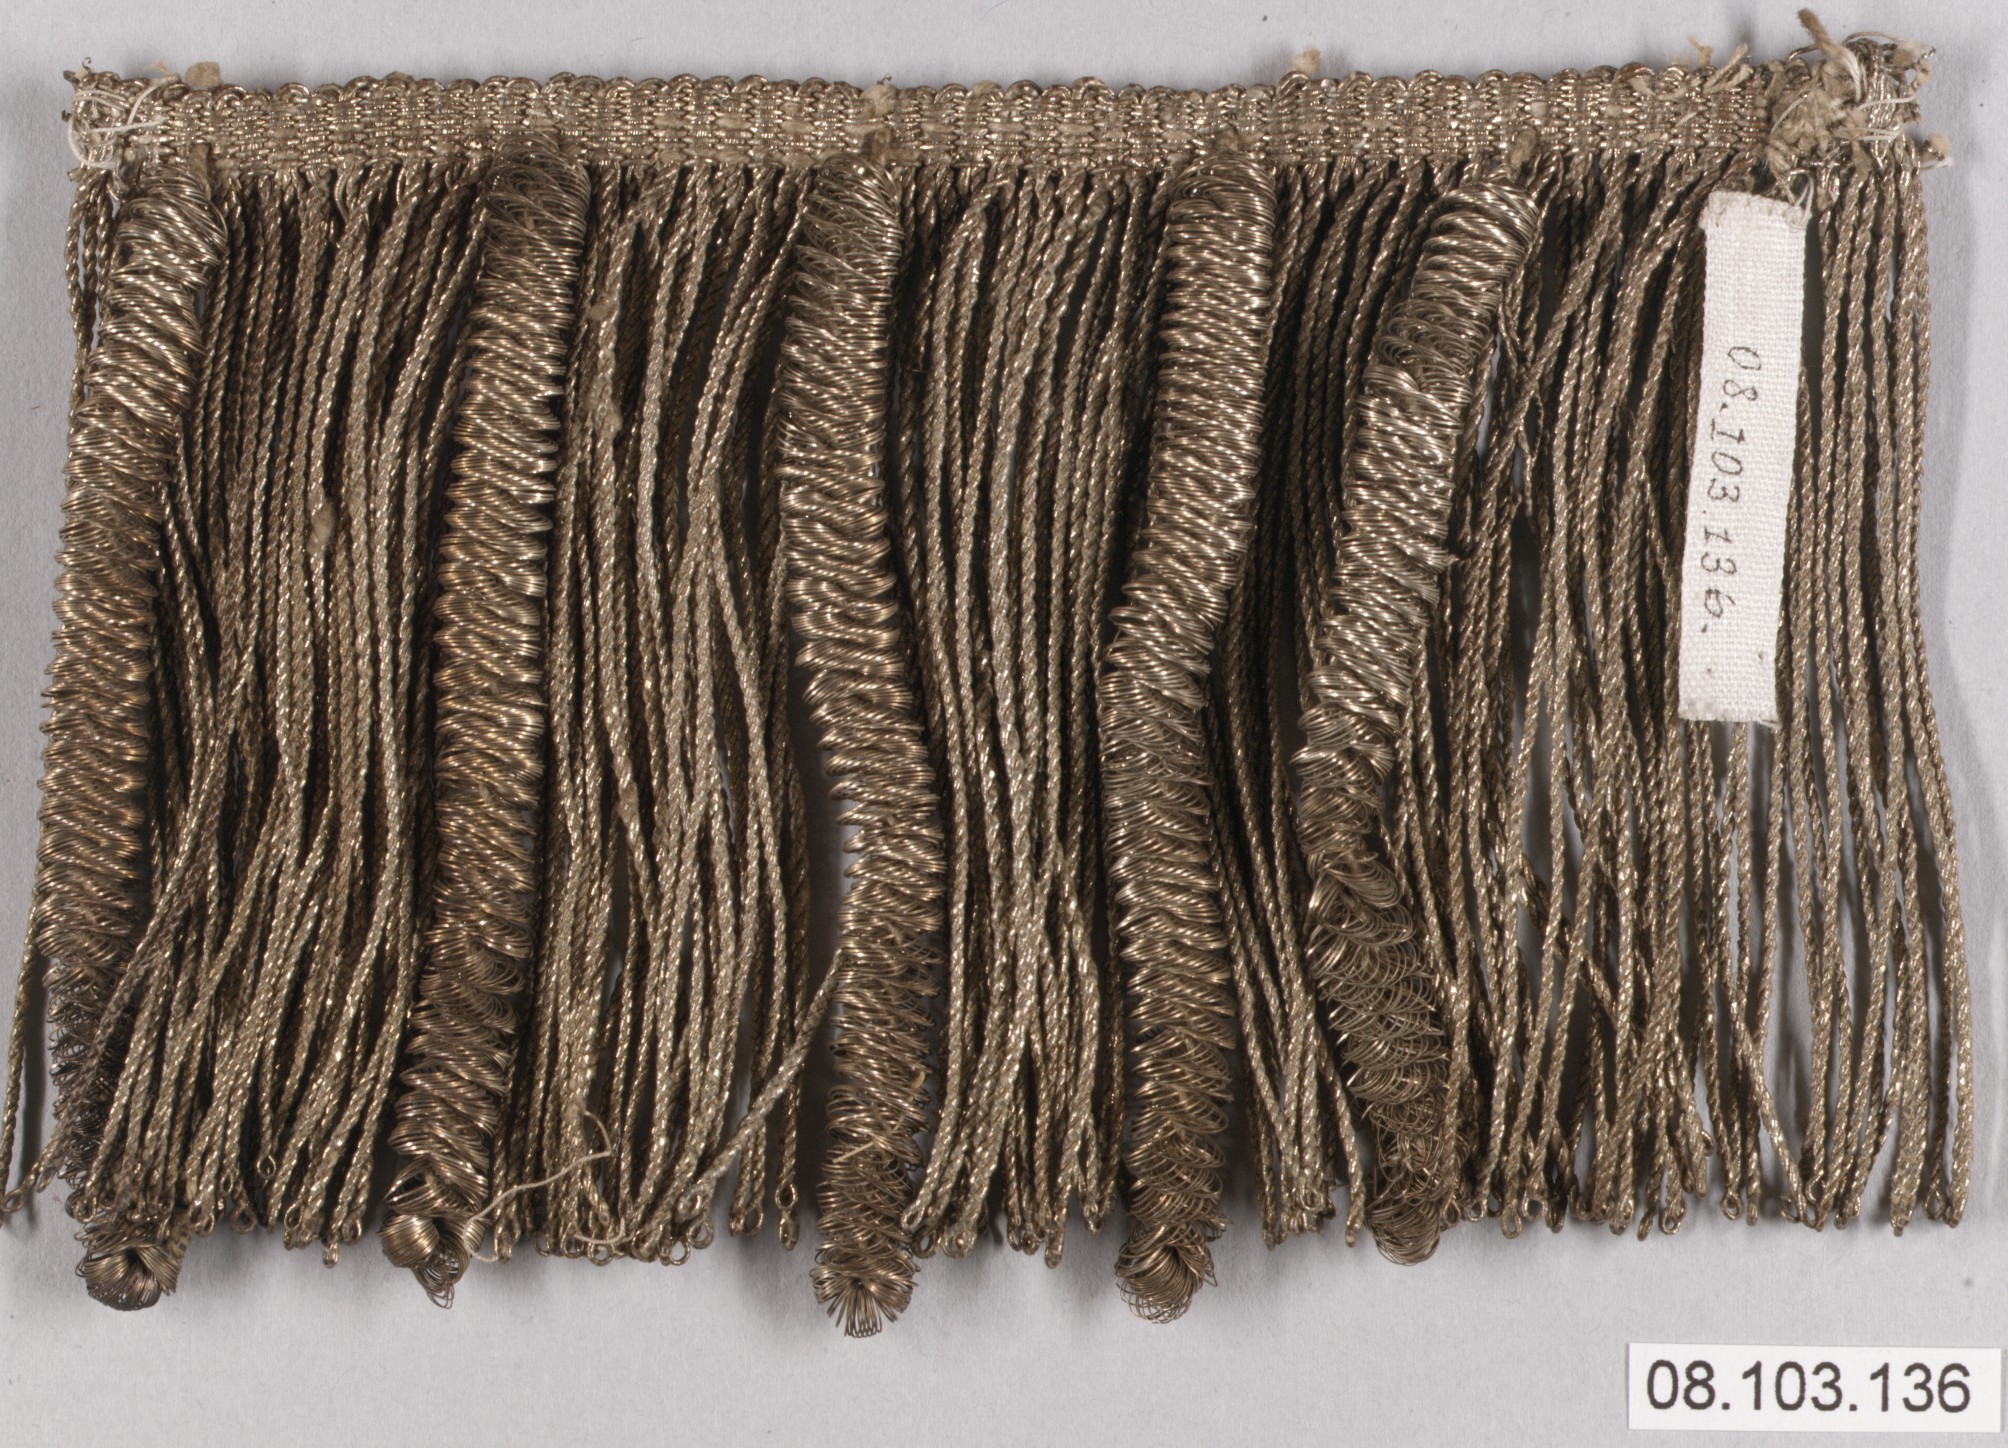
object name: fringe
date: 1801-1900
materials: metal thread